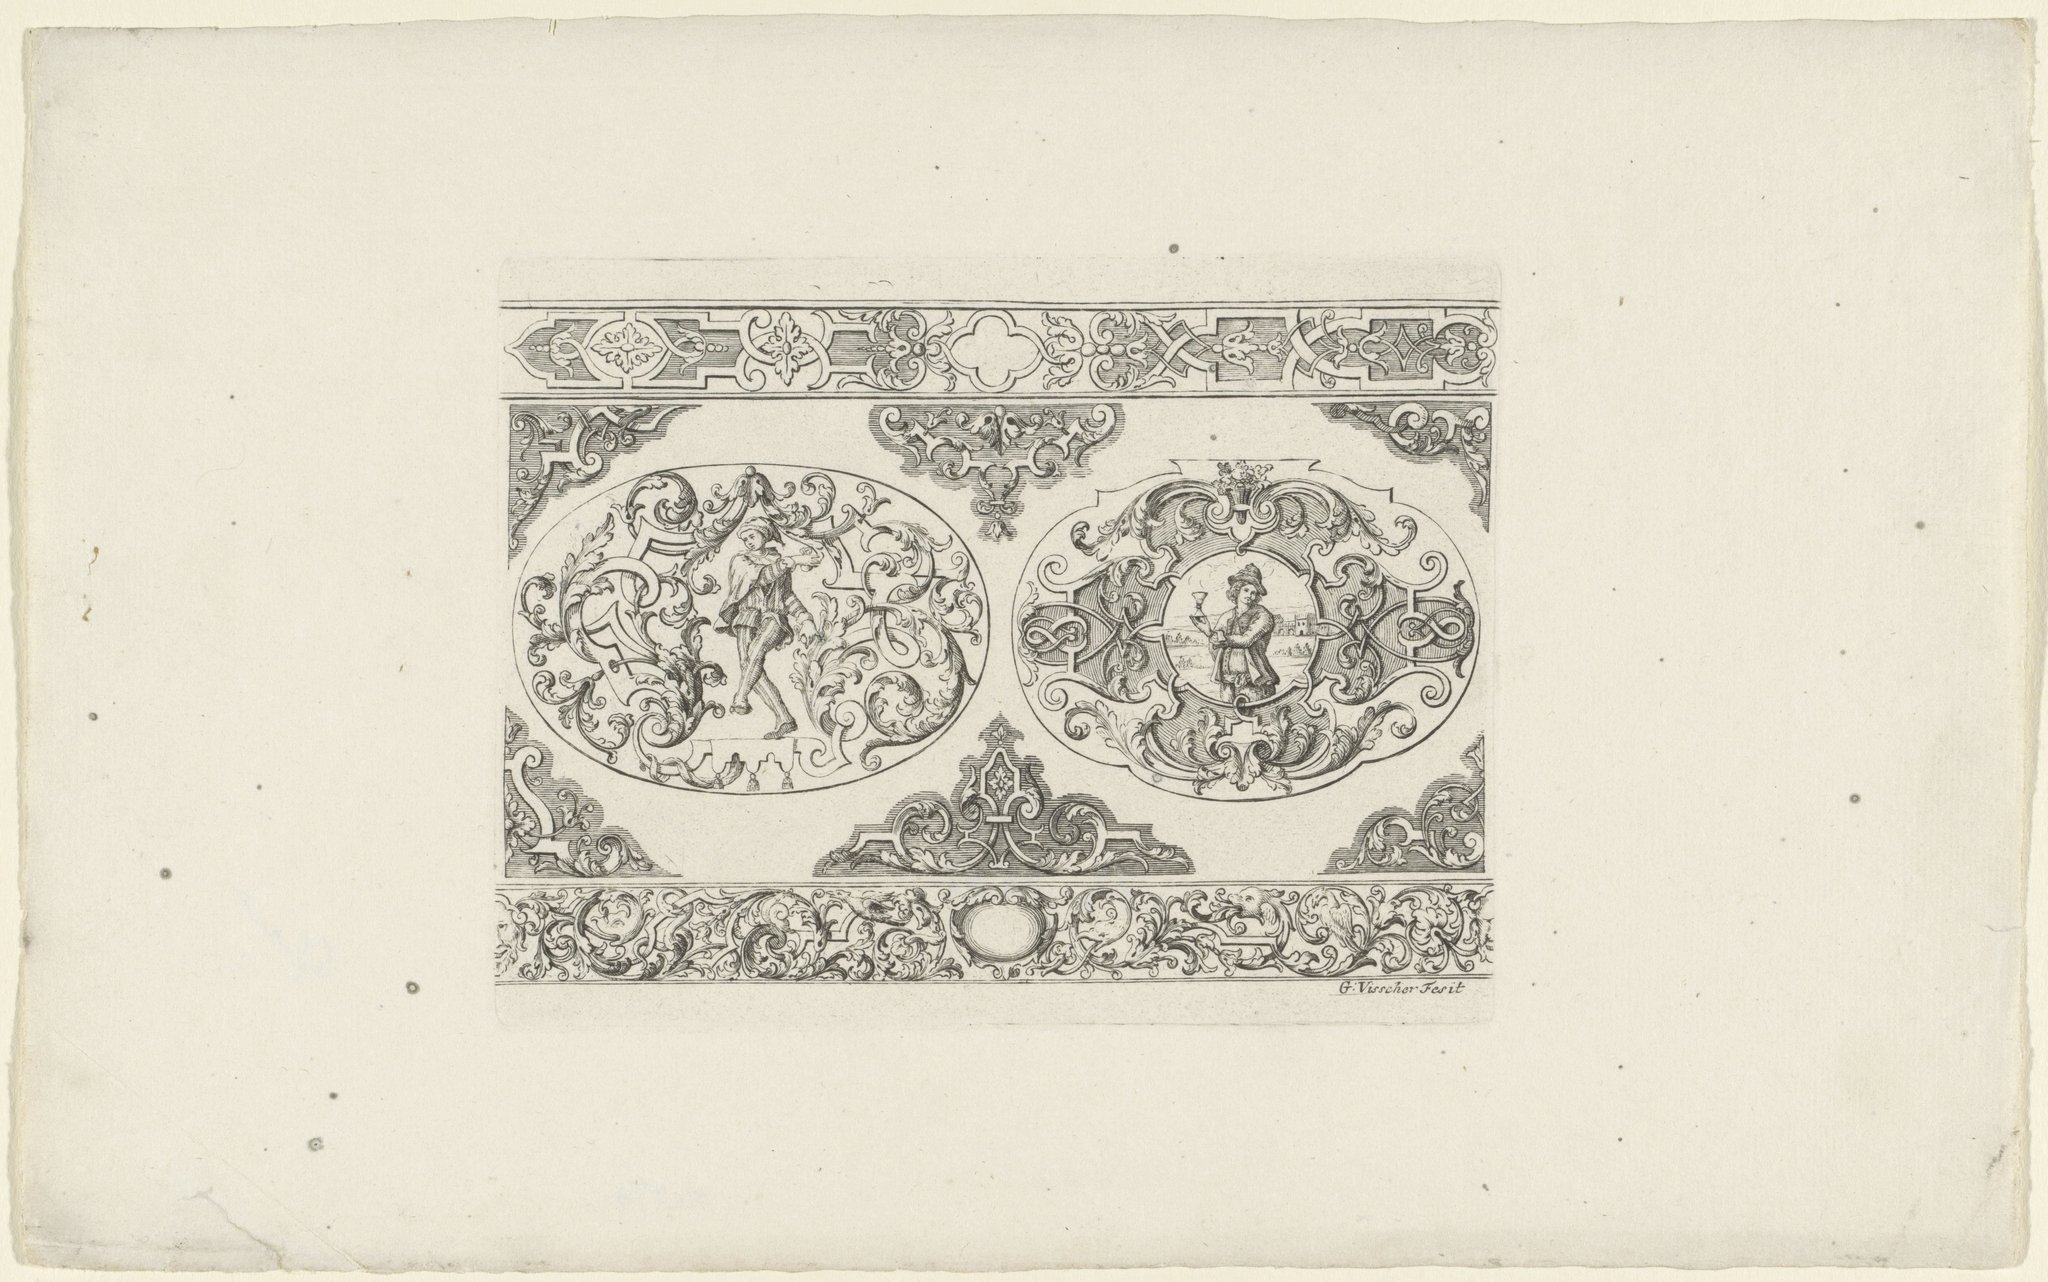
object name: print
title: Dansende nar en man met glas in ornamenten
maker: gerrit visscher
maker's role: print maker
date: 1690-1710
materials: paper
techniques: engraving, etching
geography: amsterdam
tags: ornaments ~ art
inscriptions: collector's mark: Lugt 2228